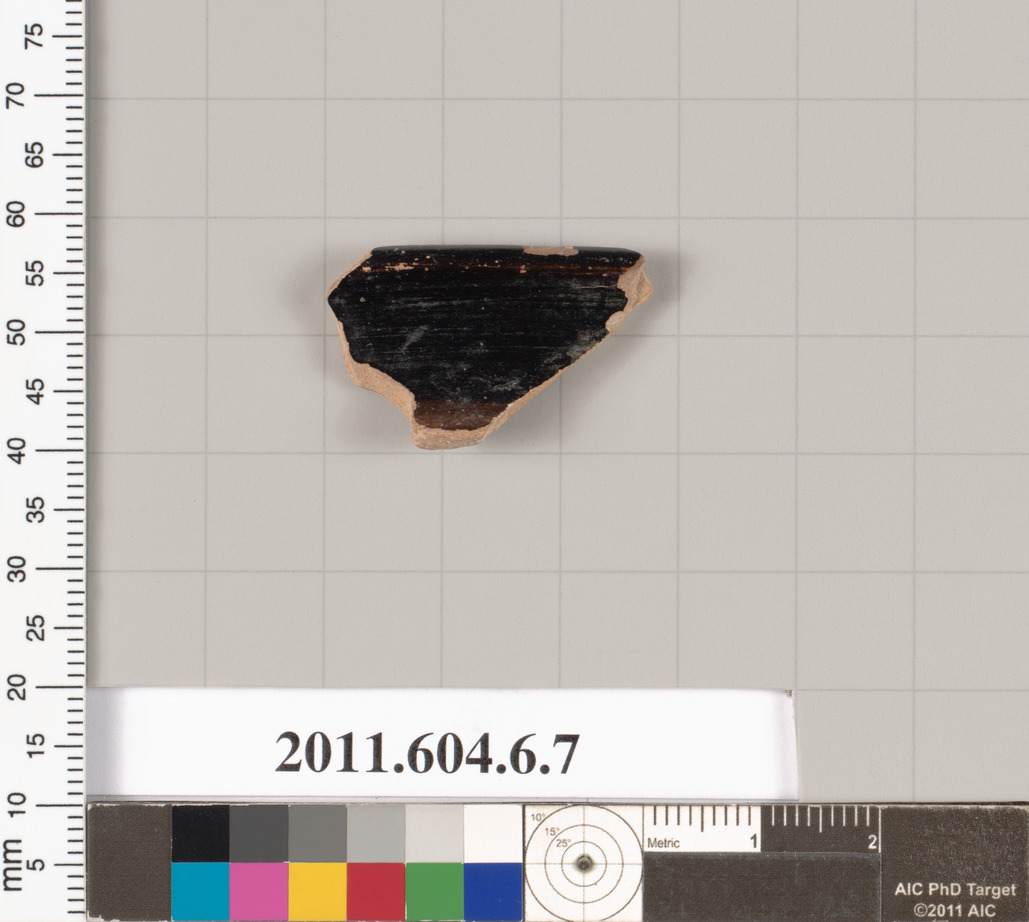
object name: undetermined open shape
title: Terracotta rim fragment of an open shape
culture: greek, attic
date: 600-401 BCE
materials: terracotta